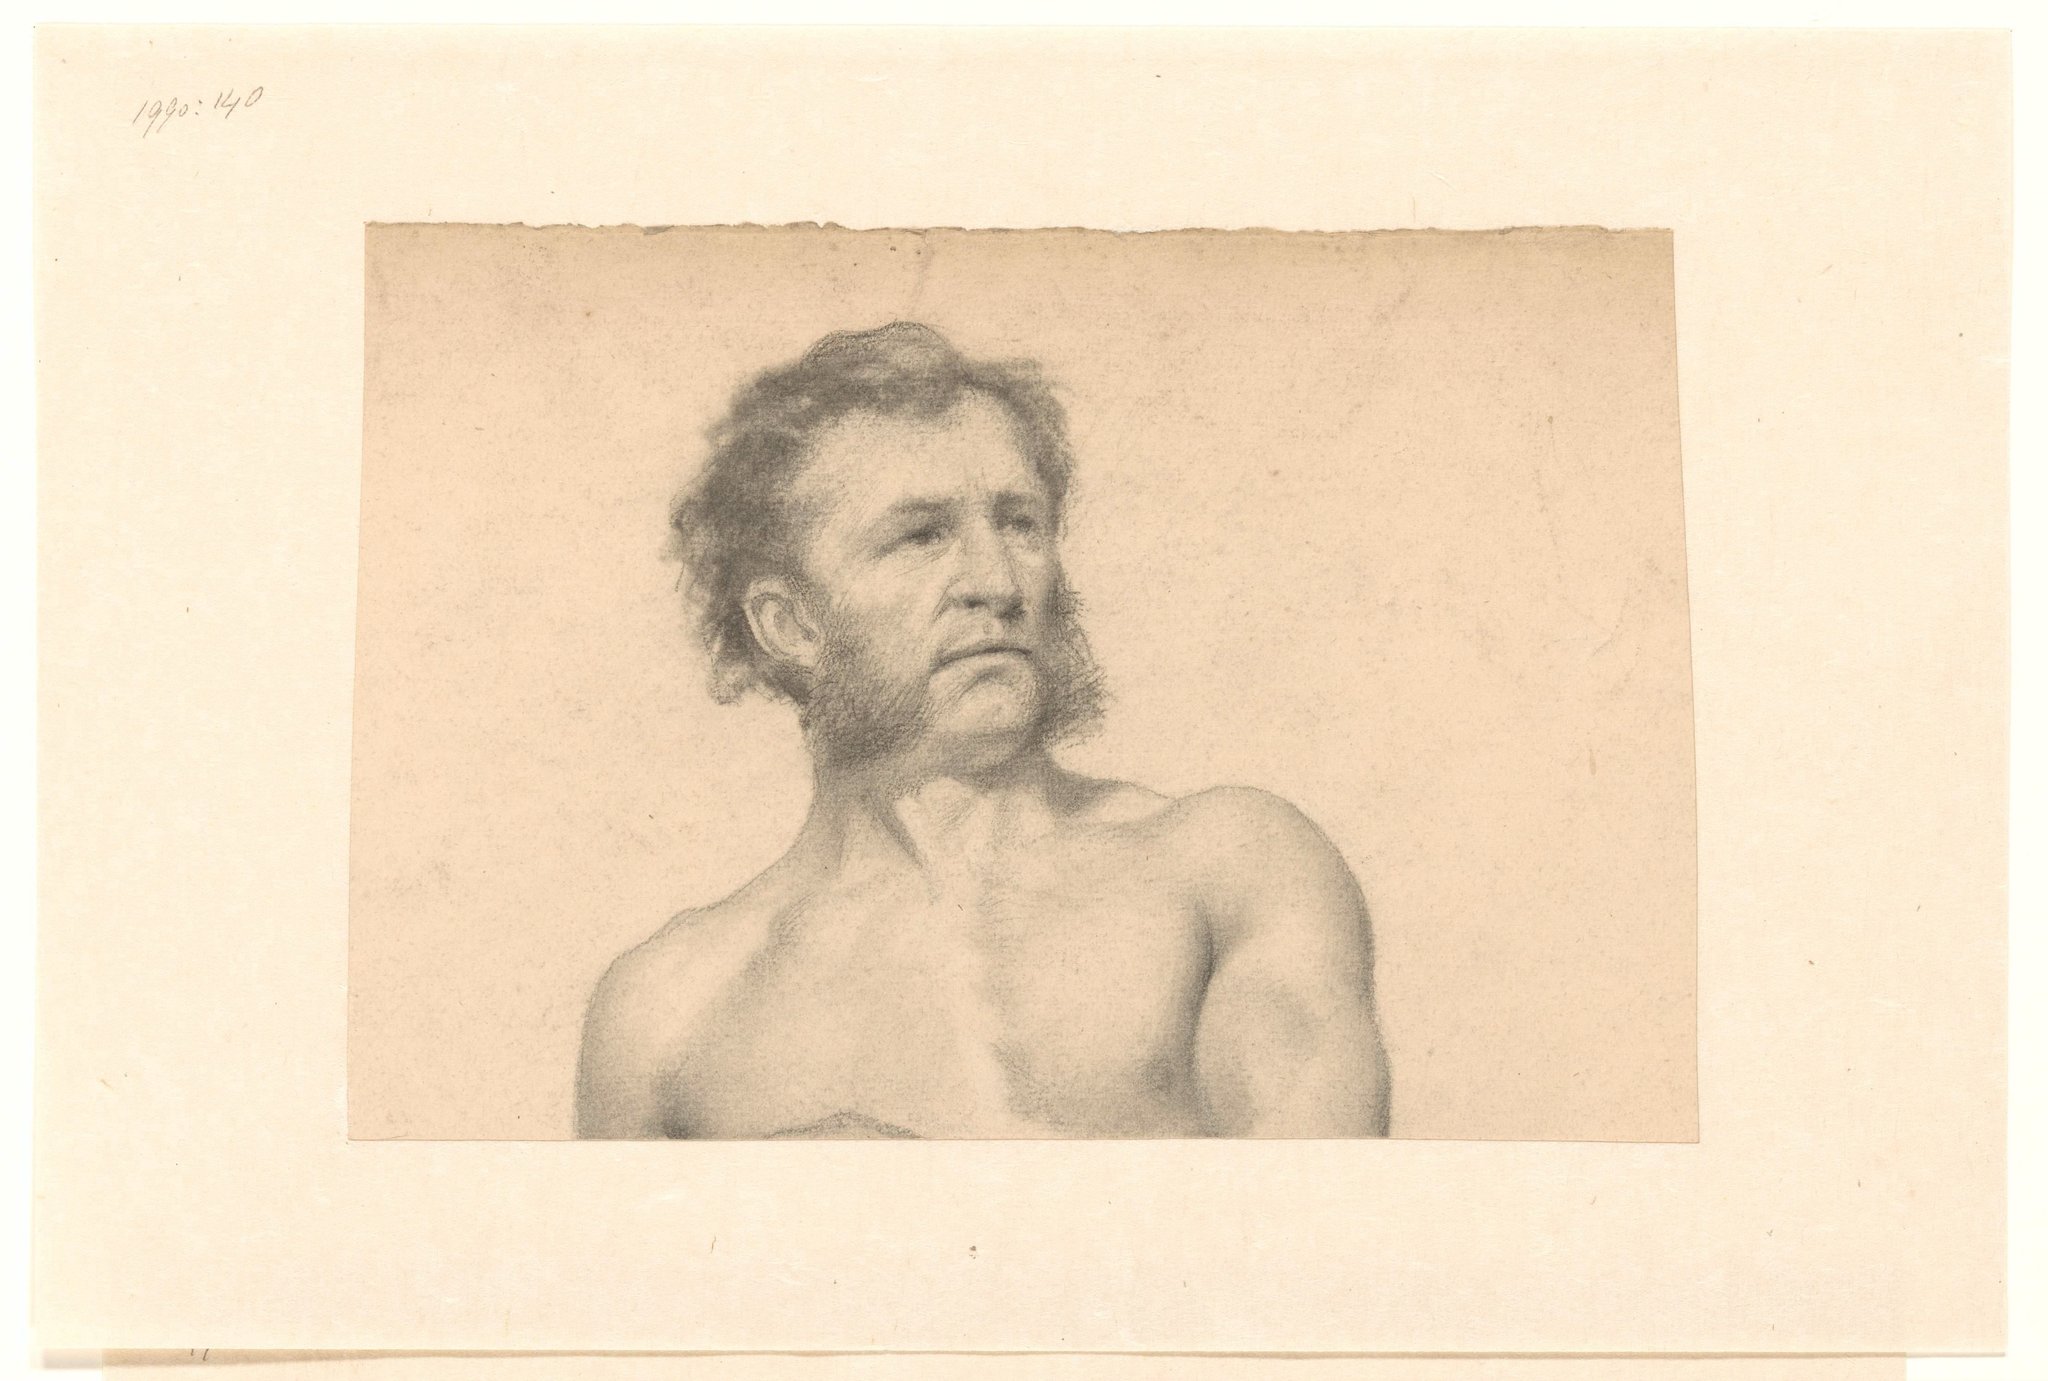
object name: drawing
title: Buste van mannelijk naakt, driekwart naar rechts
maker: johan braakensiek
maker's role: draughtsman, print maker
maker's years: 1858-1940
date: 1868-1940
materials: chalk, paper